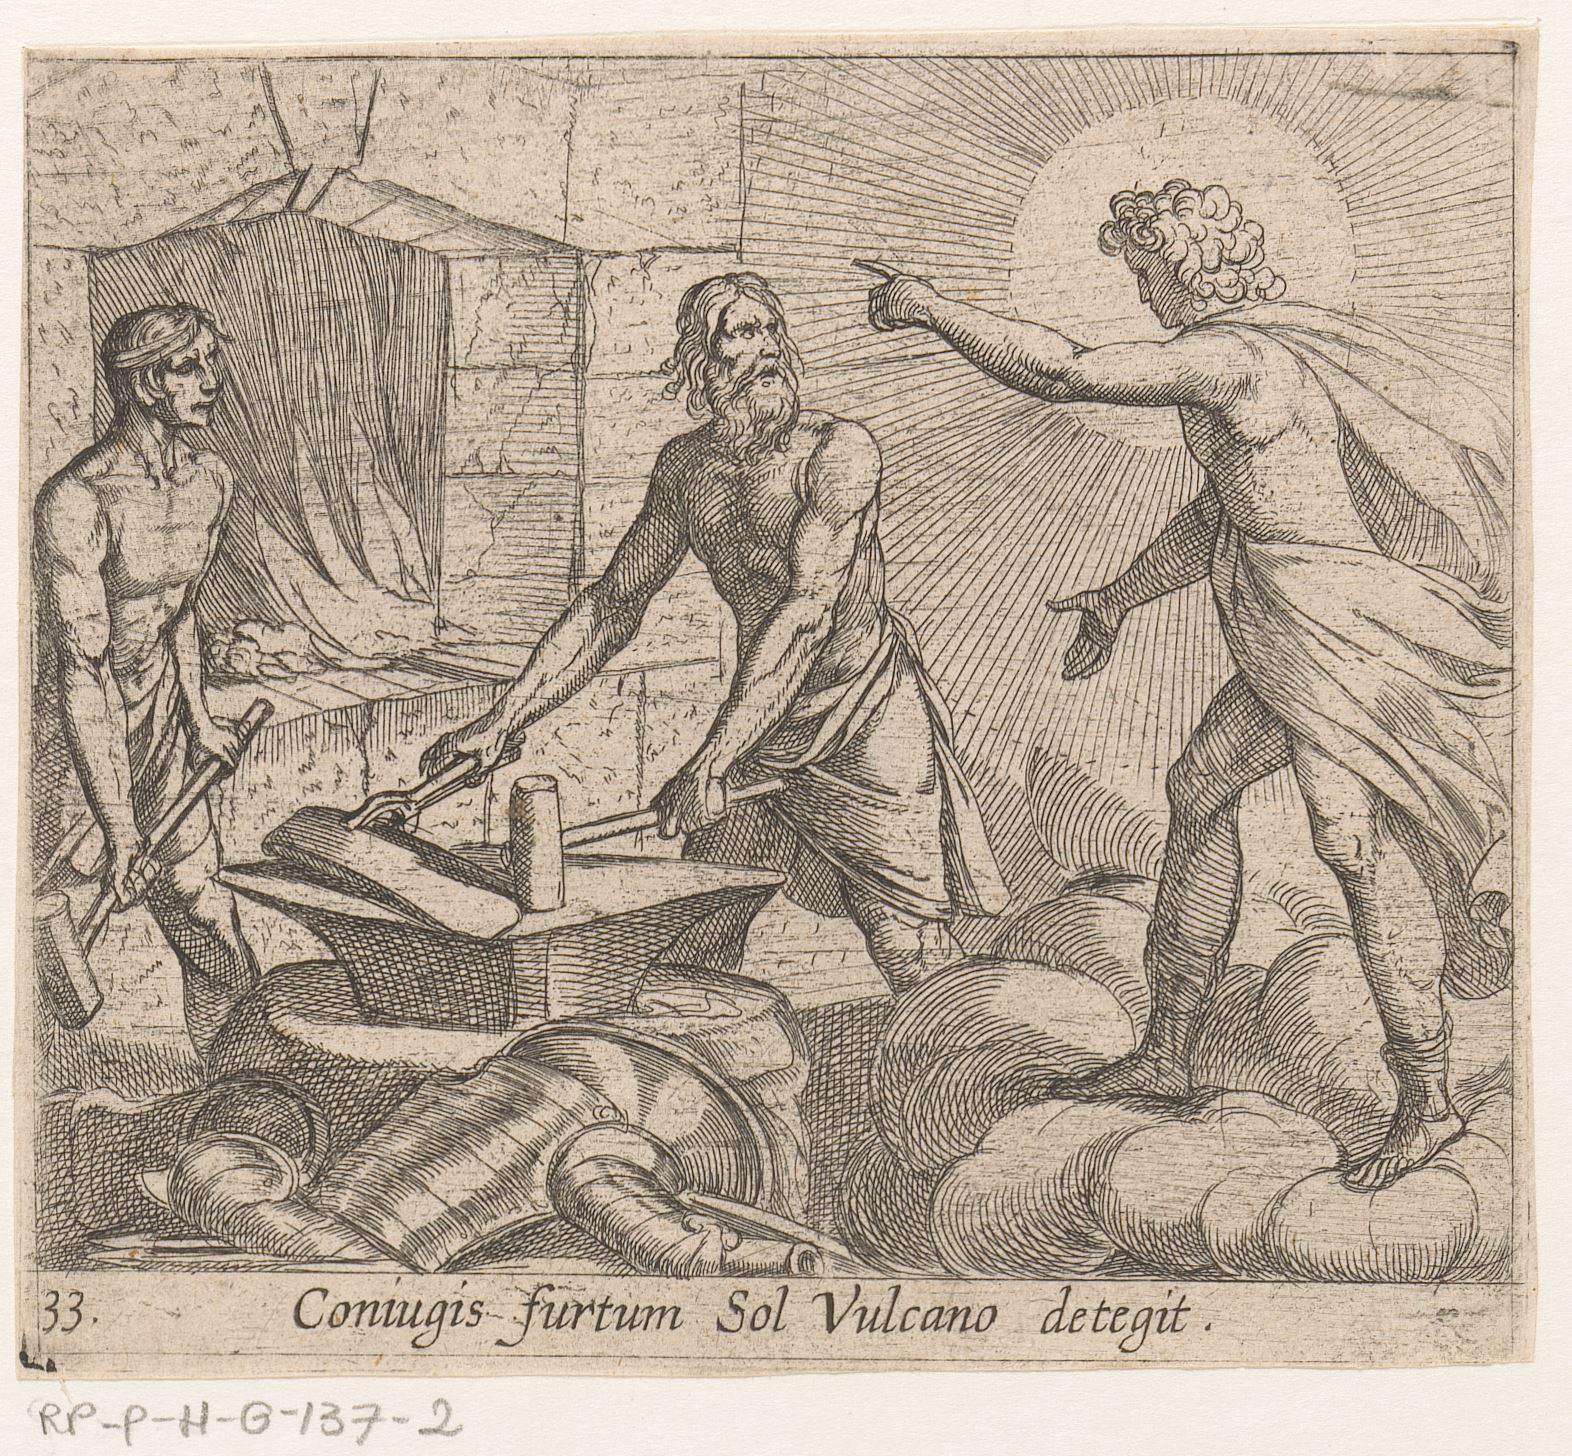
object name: print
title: Metamorfosen van Ovidius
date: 1606-1638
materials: paper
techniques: etching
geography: italy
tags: apollo in vulcan's forge revealing venus' love-affair with mars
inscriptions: collector's mark: ‘Hinloopen’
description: Apollo verschijnt in de smidse van Vulcanus. Vulcanus en zijn assistent kijken op van hun werk. Titel in het Latijn in ondermarge.